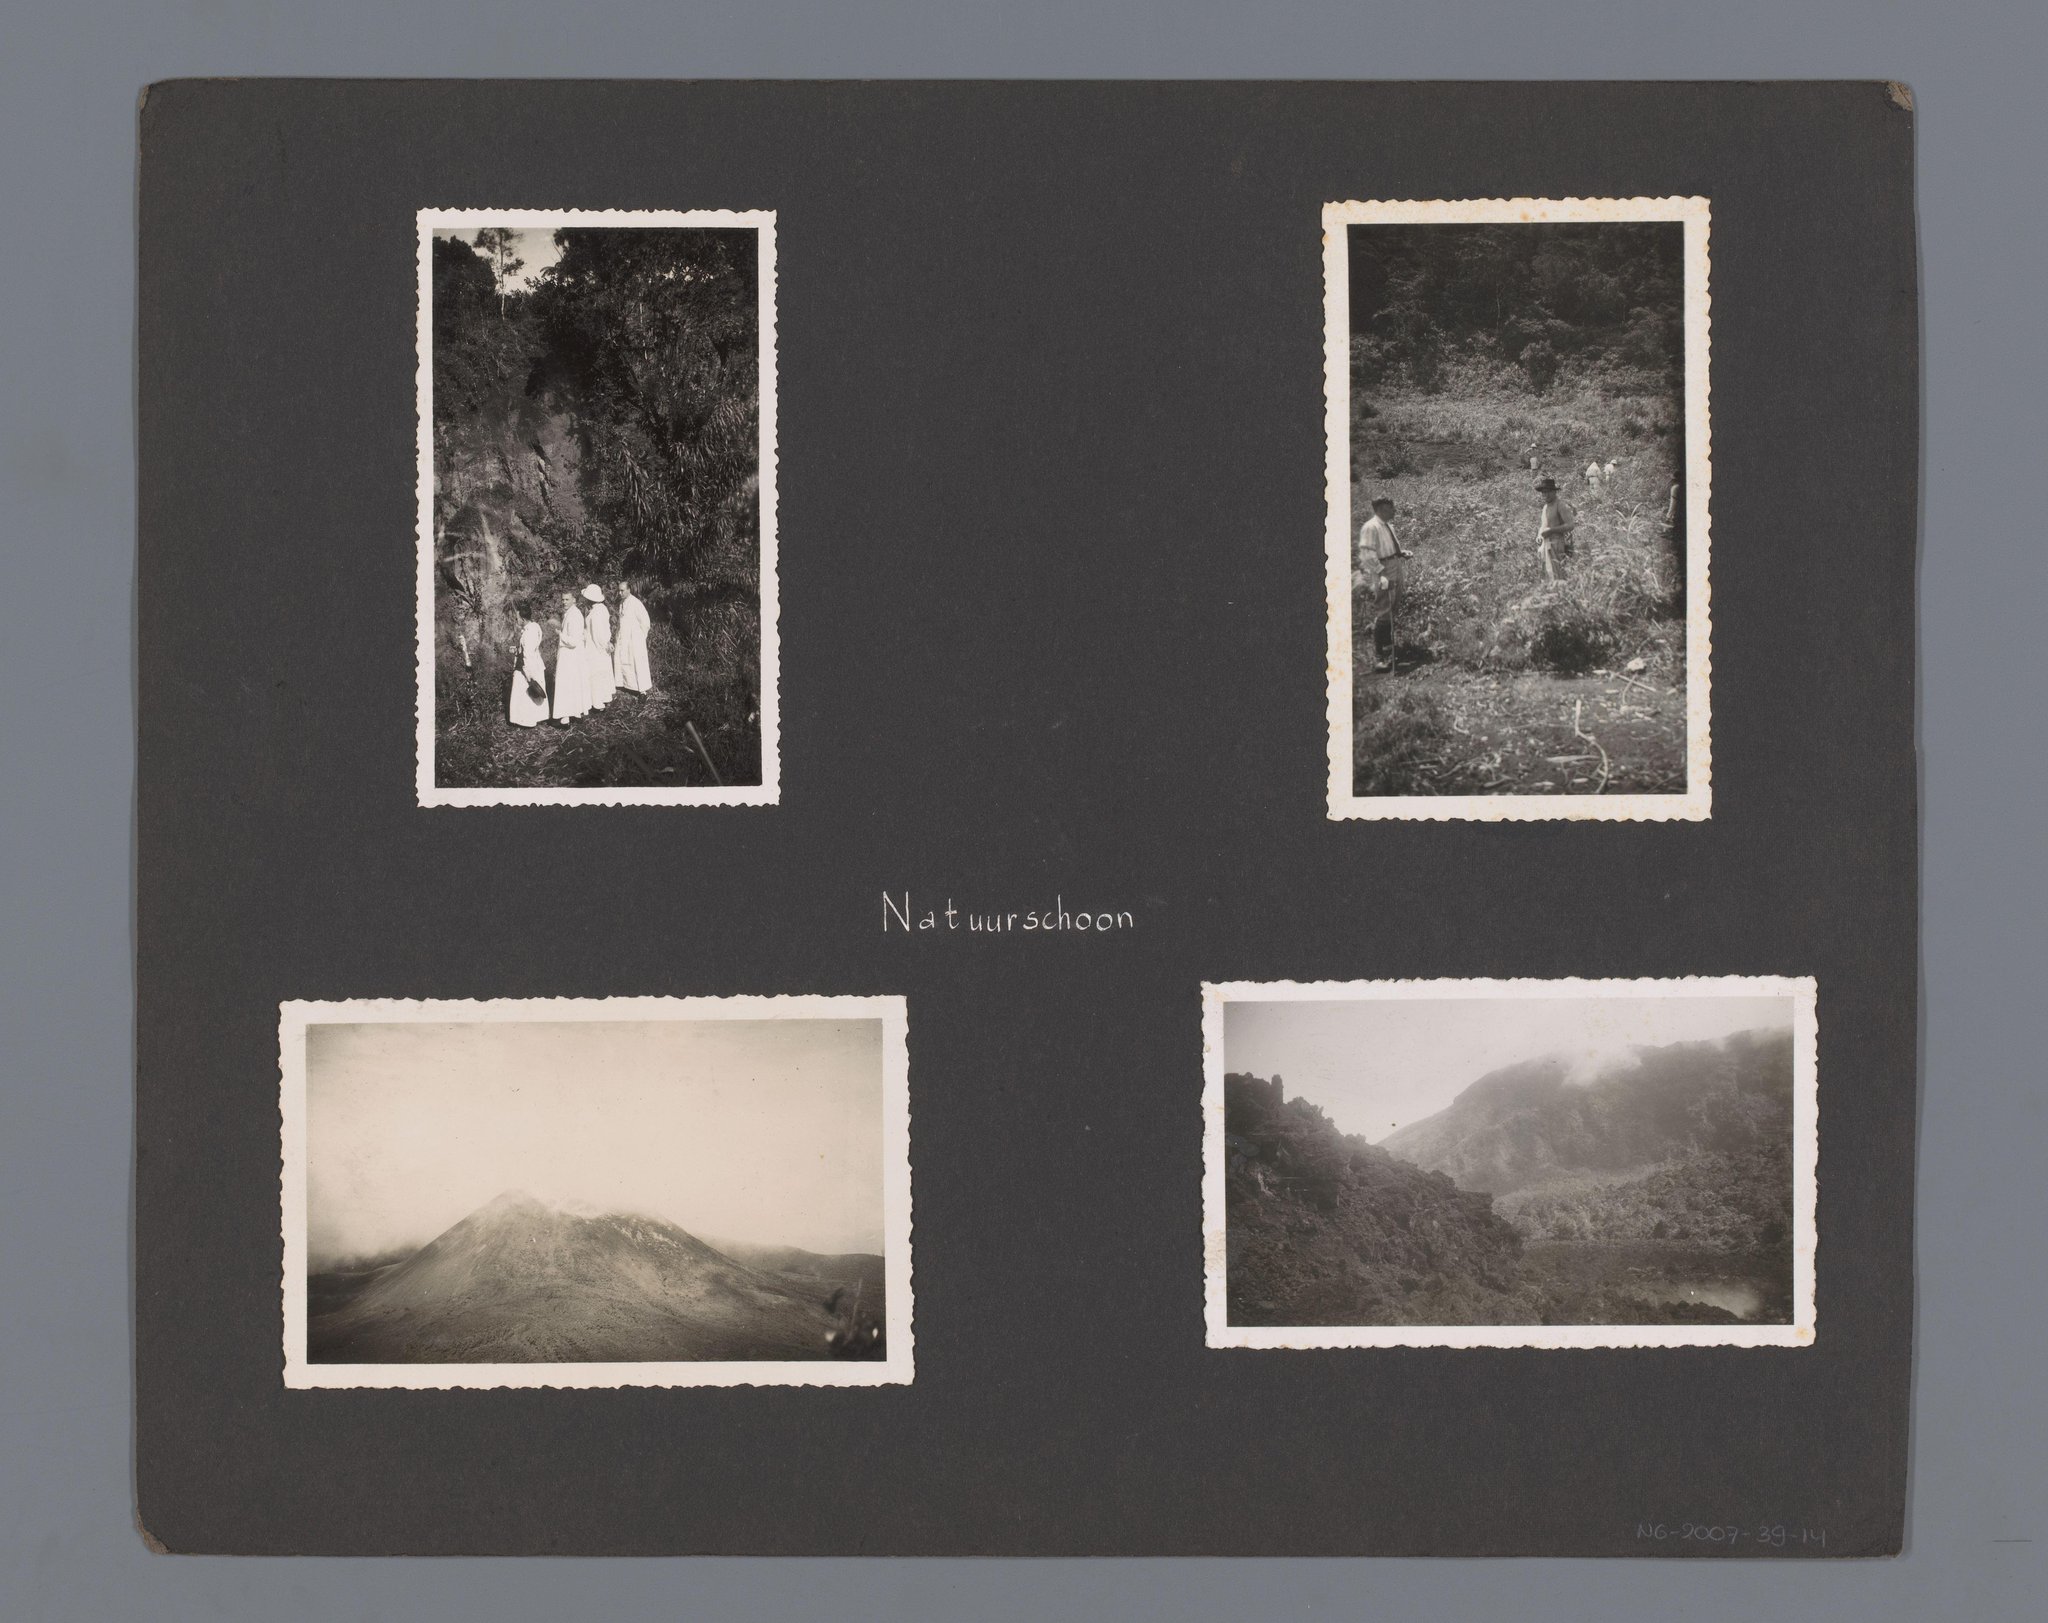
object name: album leaf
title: Natuurschoon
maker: Anonymous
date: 1930-1939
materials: paper, photographic support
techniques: gelatin silver print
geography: dutch east indies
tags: landscapes in tropical and sub-tropical regions, dutch east indies, the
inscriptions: annotation: ‘Natuurschoon’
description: Zwart albumblad met vier foto's van natuurgezichten in Nederlands-Indië, waarschijnlijk op Celebes. Op een foto zijn enkele fraters te zien. Onderdeel van het losbladig fotoalbum over de Fraters van Tilburg op Celebes en Sumatra.